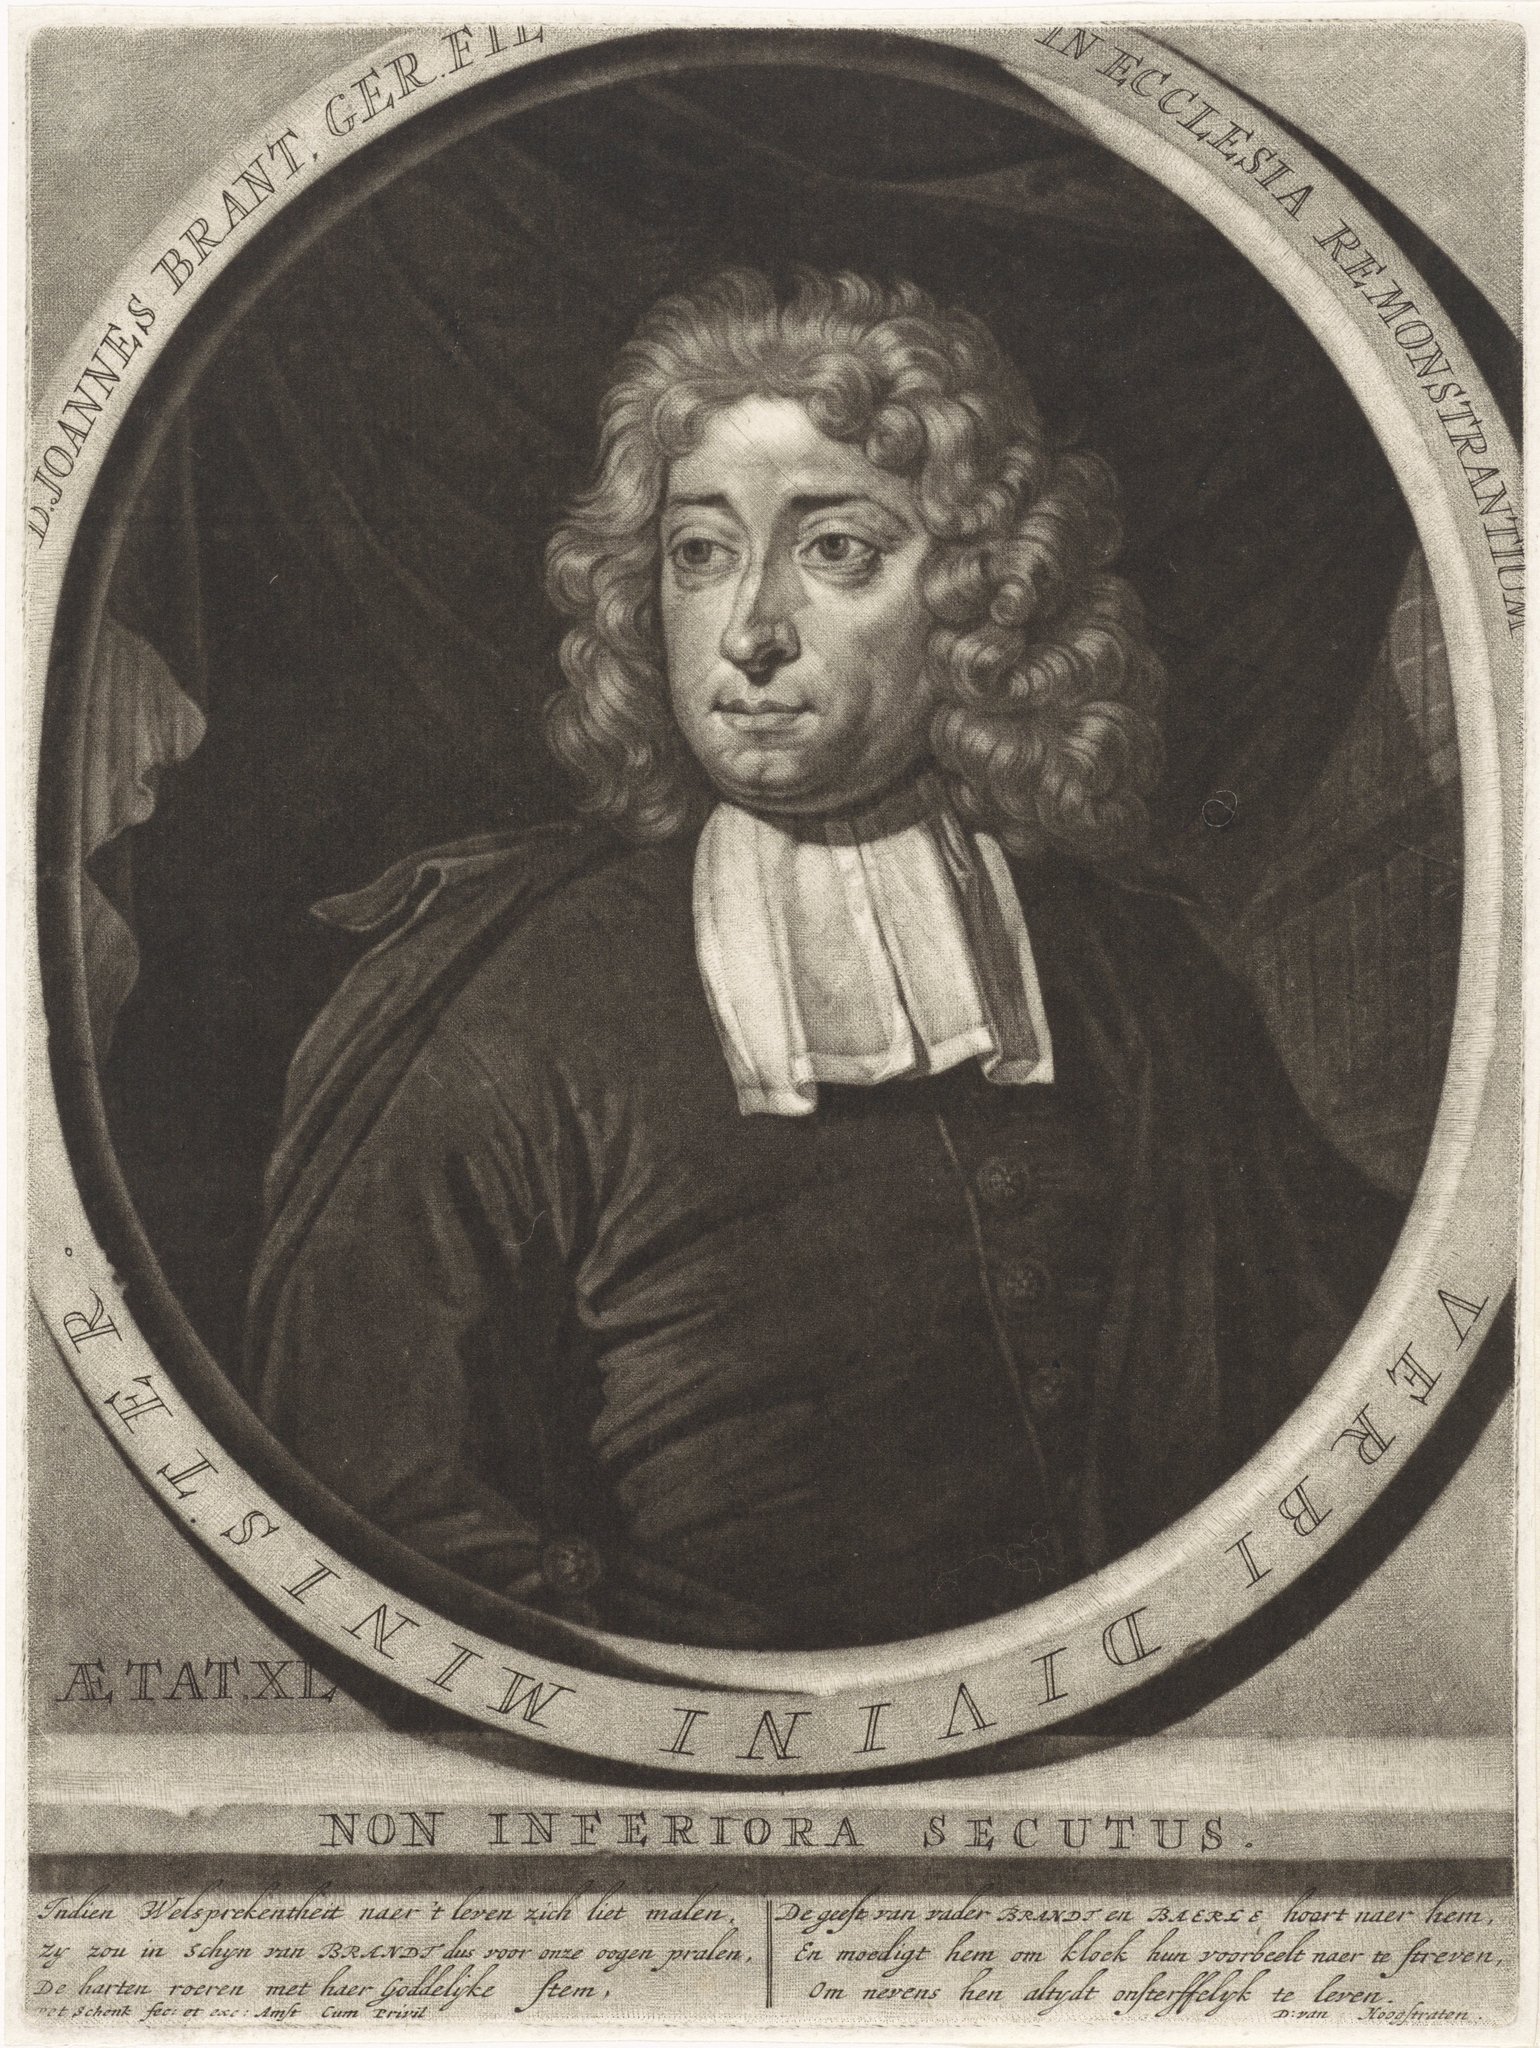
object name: print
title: Portret van de theoloog en schrijver Joannes Brandt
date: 1670-1713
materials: paper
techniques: engraving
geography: amsterdam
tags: amsterdam, joannes brandt, theologian, book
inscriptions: collector's mark: Lugt 2228